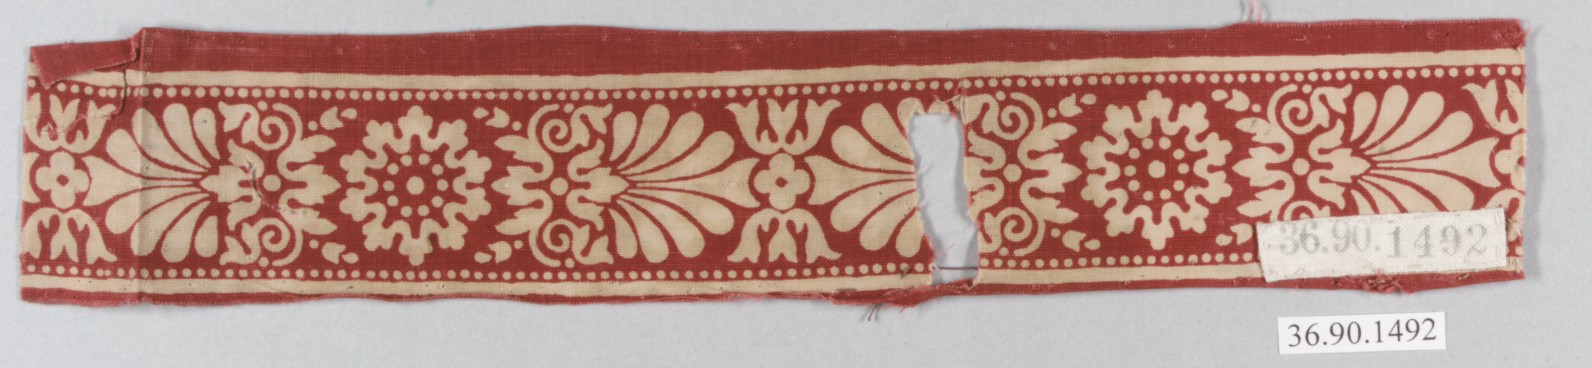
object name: ribbon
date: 1801-1900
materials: cotton